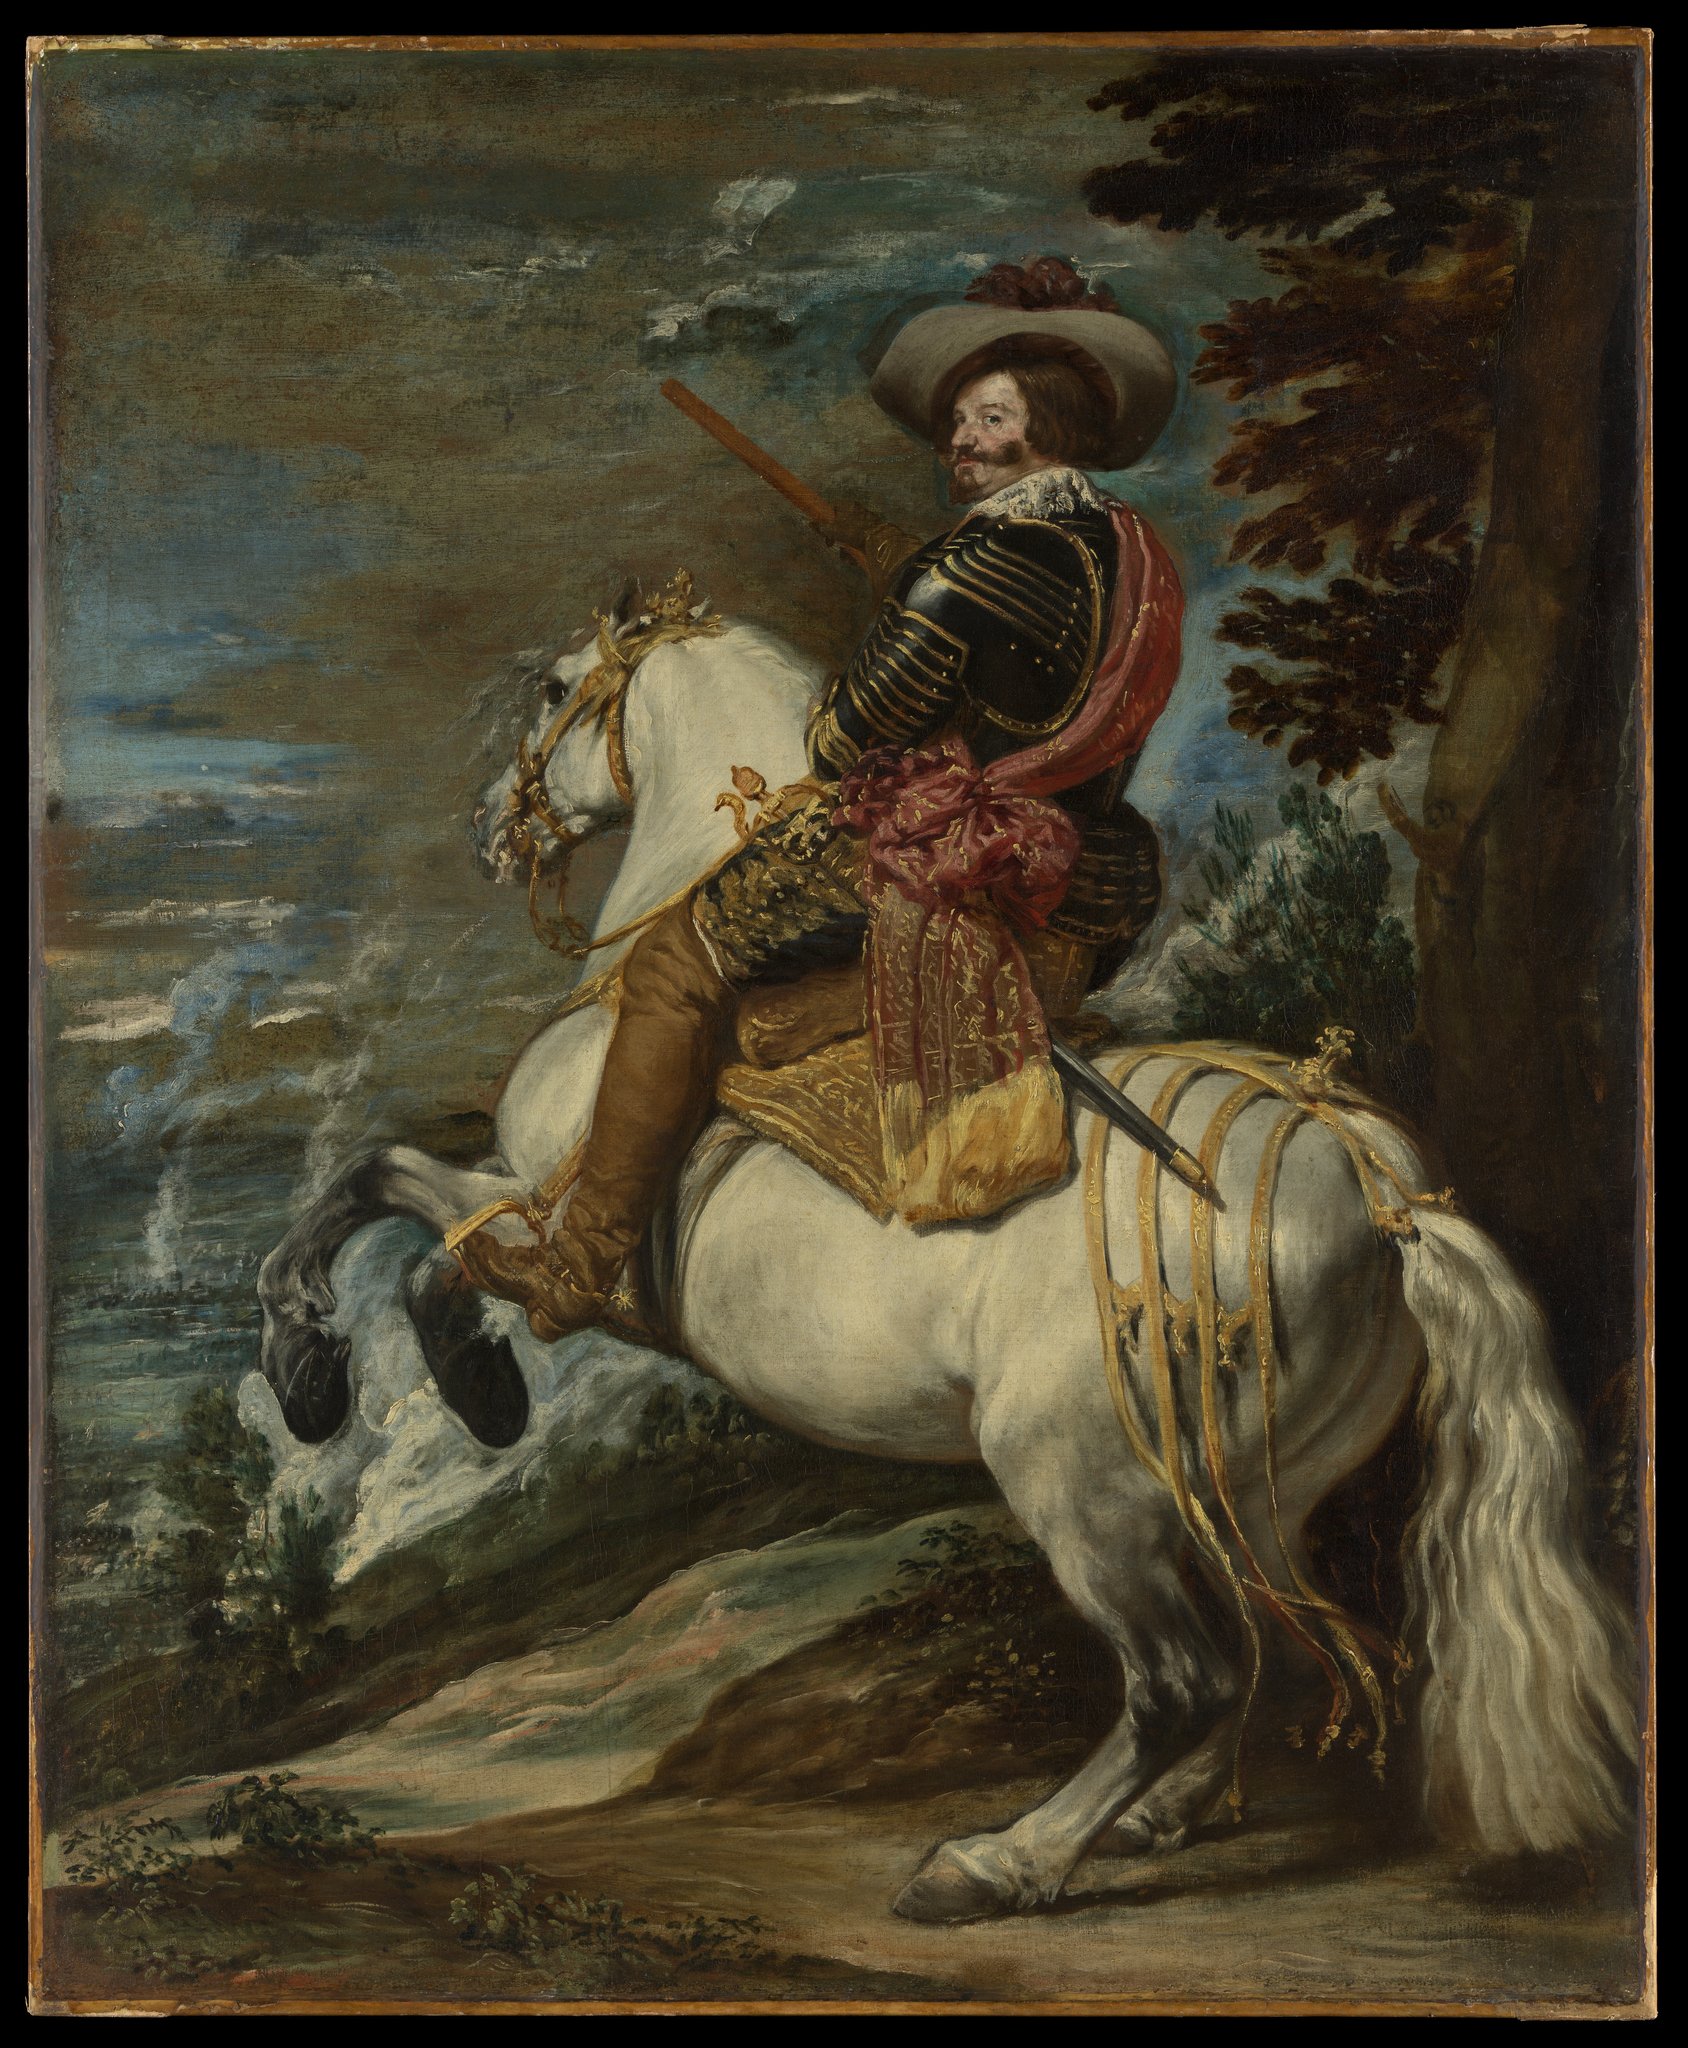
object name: painting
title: Don Gaspar de Guzmán (1587–1645), Count-Duke of Olivares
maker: juan bautista martínez del mazo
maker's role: artist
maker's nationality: spanish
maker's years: 1612-1667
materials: canvas, oil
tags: men,portraits,horses